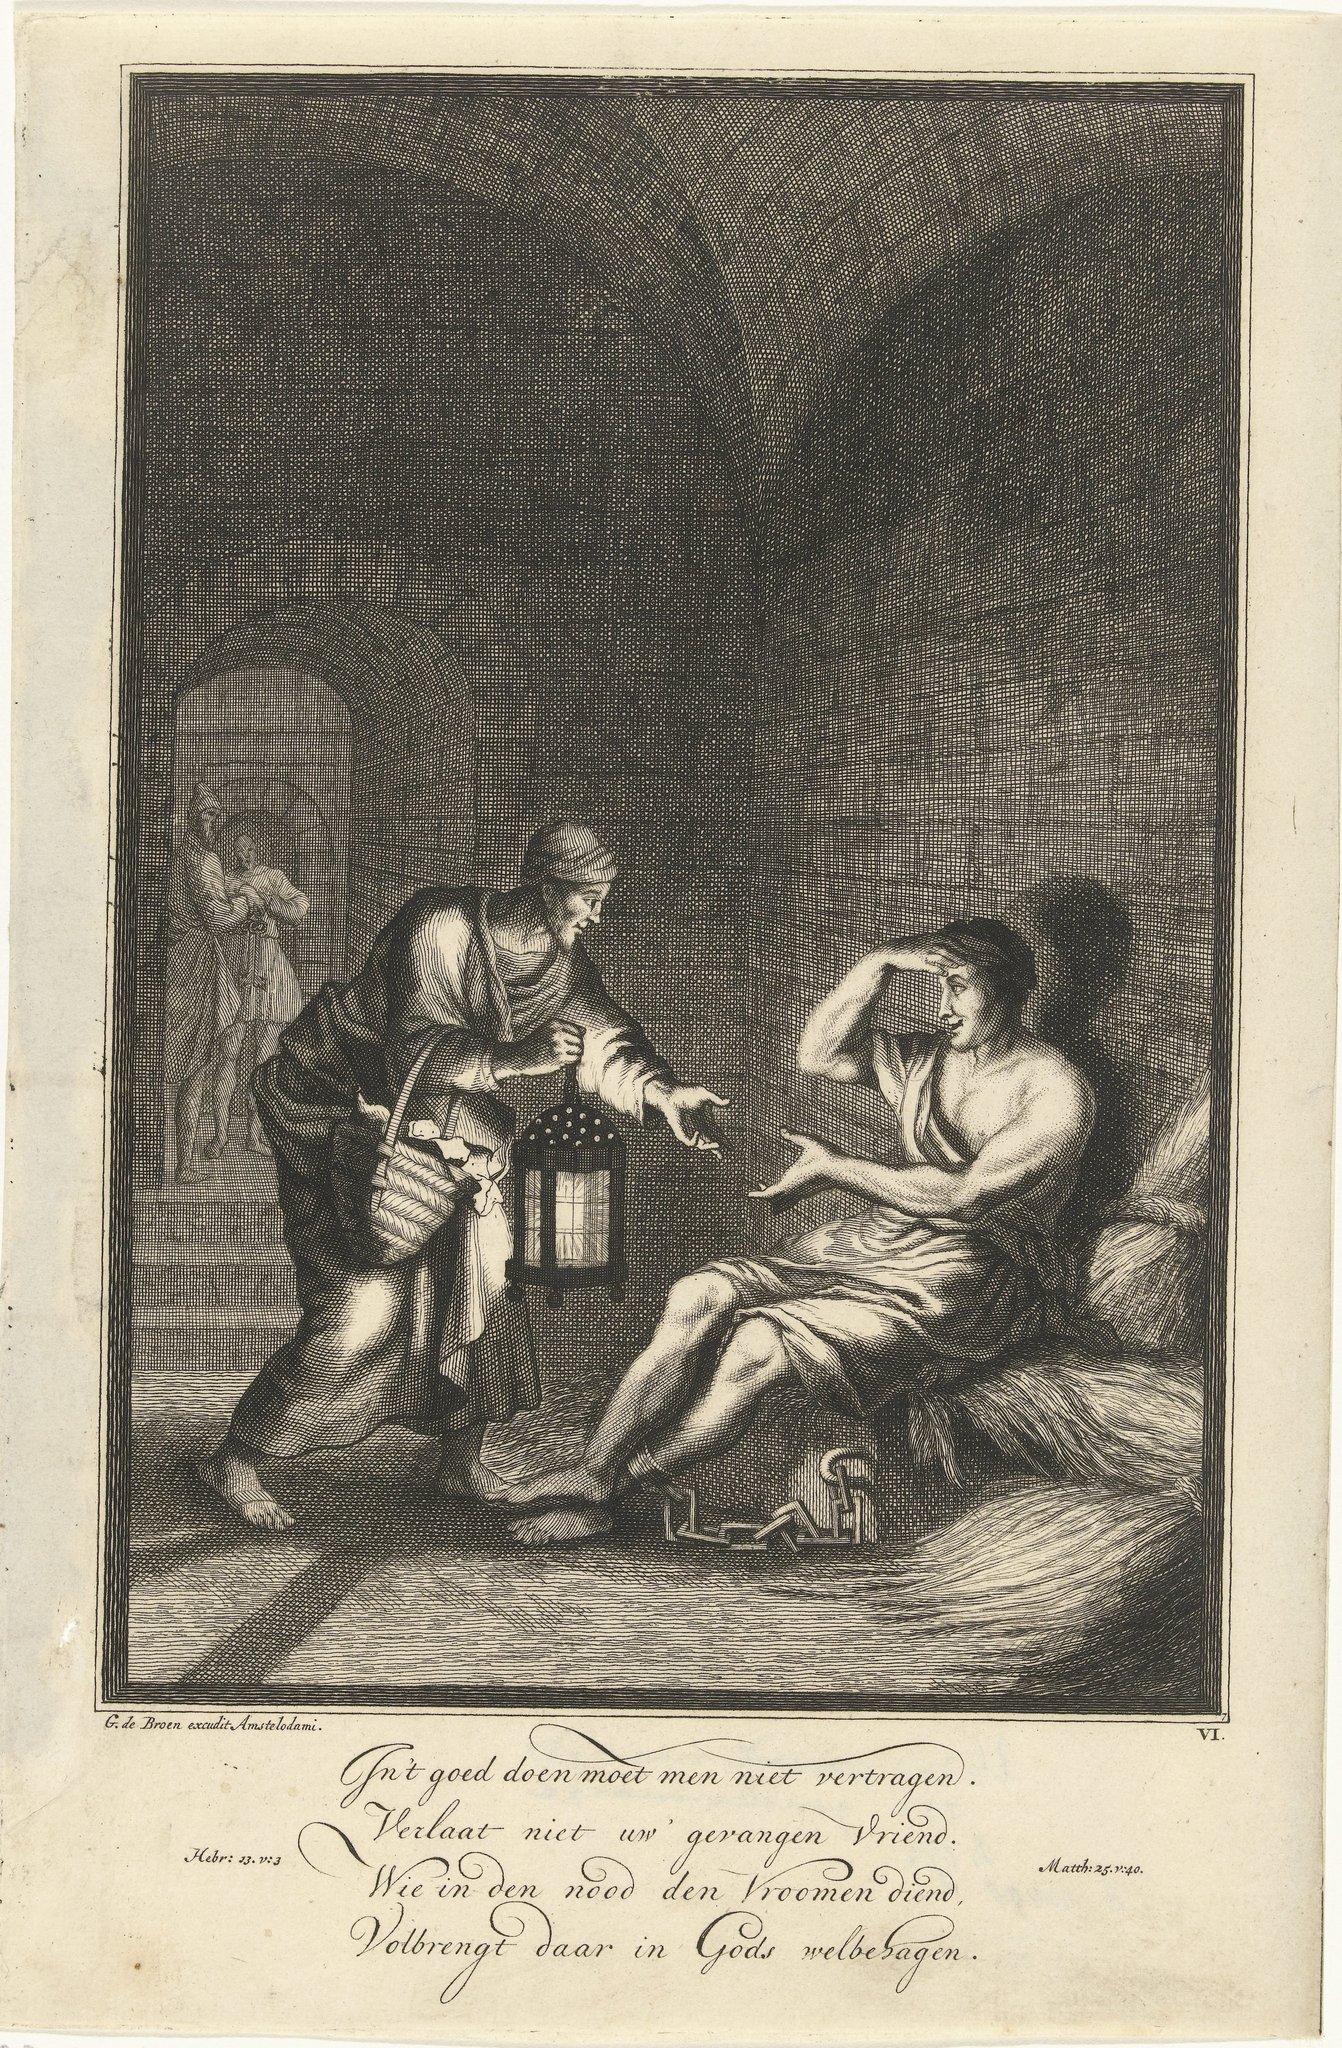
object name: print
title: De gevangenen bezoeken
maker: gerrit de broen (i)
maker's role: print maker, publisher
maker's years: 1659-1740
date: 1695-1740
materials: paper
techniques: engraving, etching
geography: amsterdam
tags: visiting or liberating the imprisoned, 'incarceratus solatur' ~ one of the (seven) acts of mercy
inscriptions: collector's mark: Lugt 2228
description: Een man brengt een gevangene eten. De gevangene zit op een steen in een donkere ruimte en is met een ketting vastgemaakt. De bezoeker komt met een lantaarn en strekt zijn hand uit om de gevangene te begroeten.